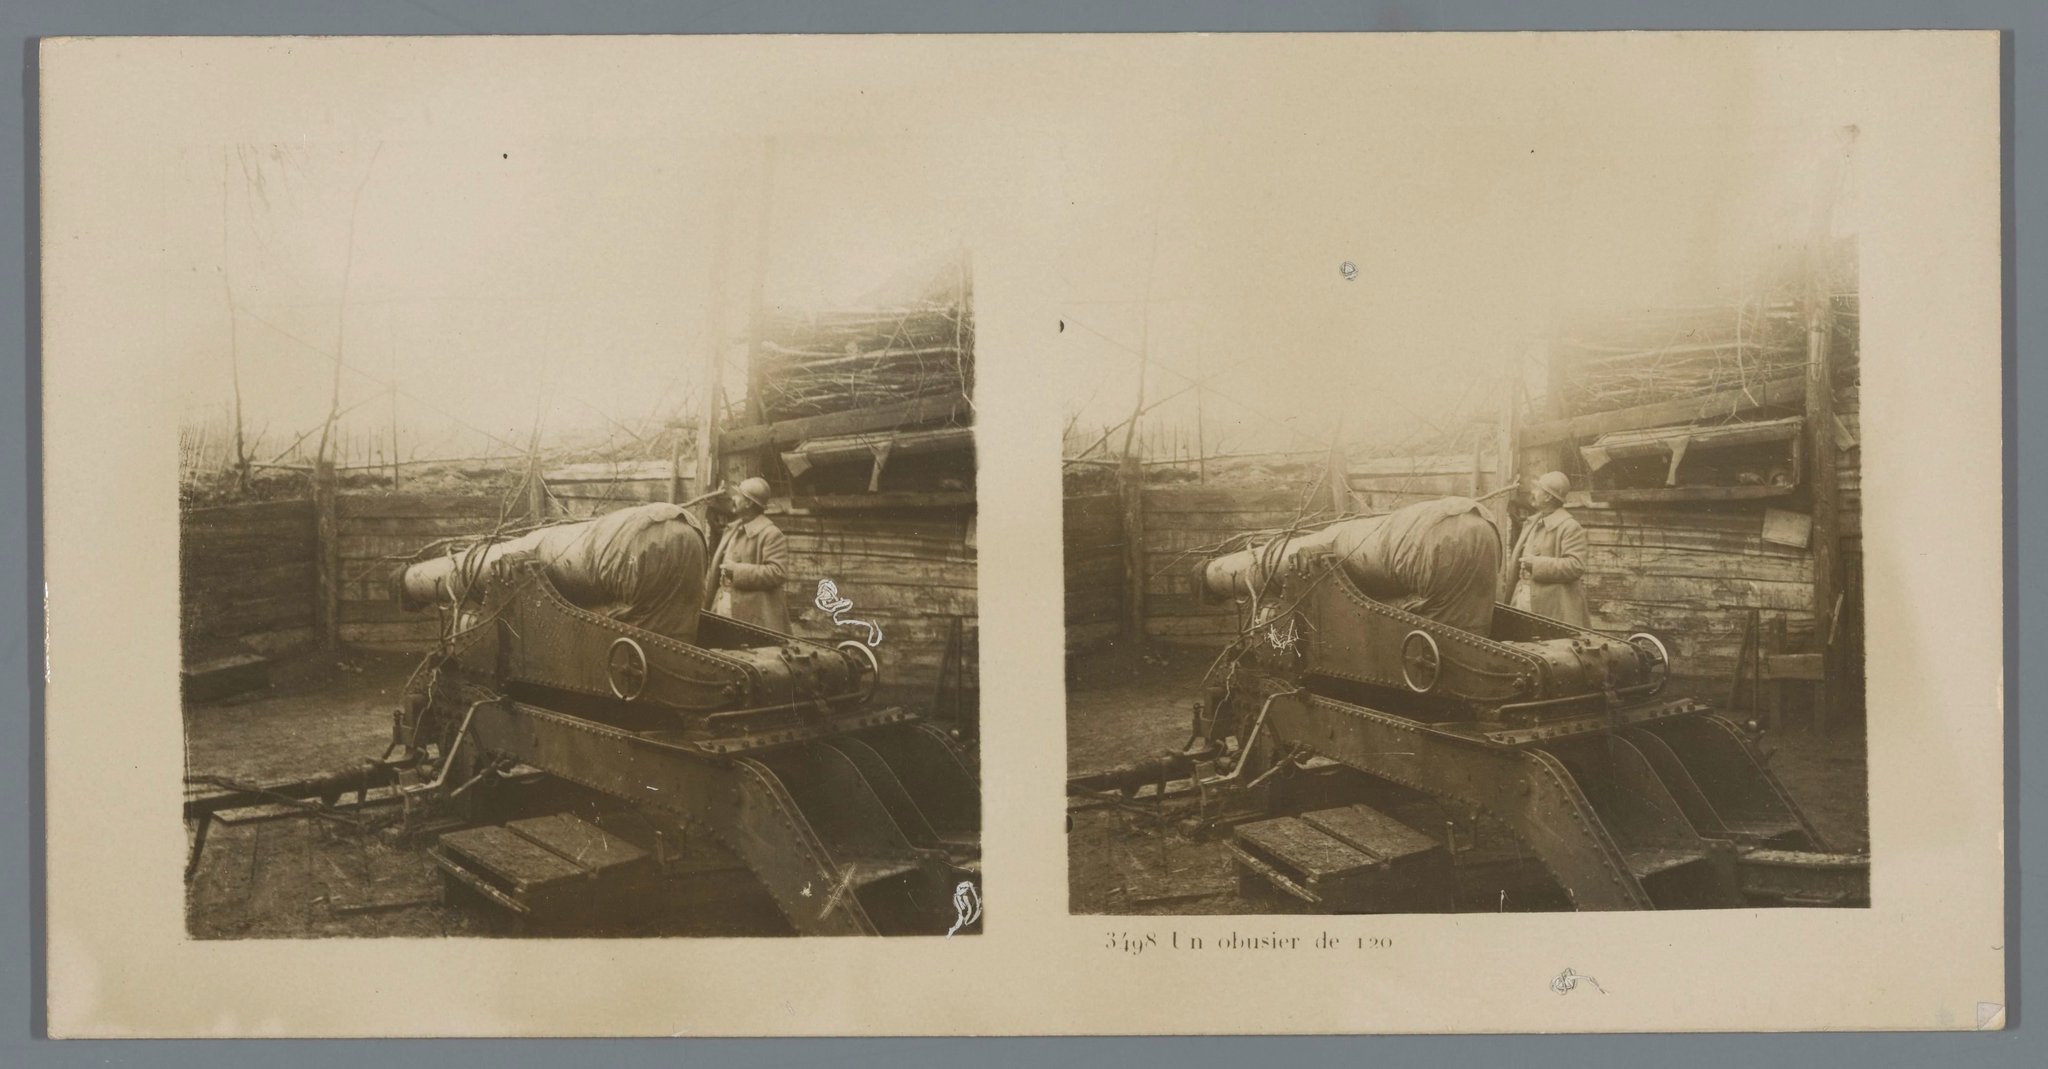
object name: stereograph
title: Soldaat naast een houwitser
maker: Anonymous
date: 1914-1918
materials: cardboard, photographic support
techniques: gelatin silver print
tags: private soldier, firearms: cannon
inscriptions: number: ‘3498’